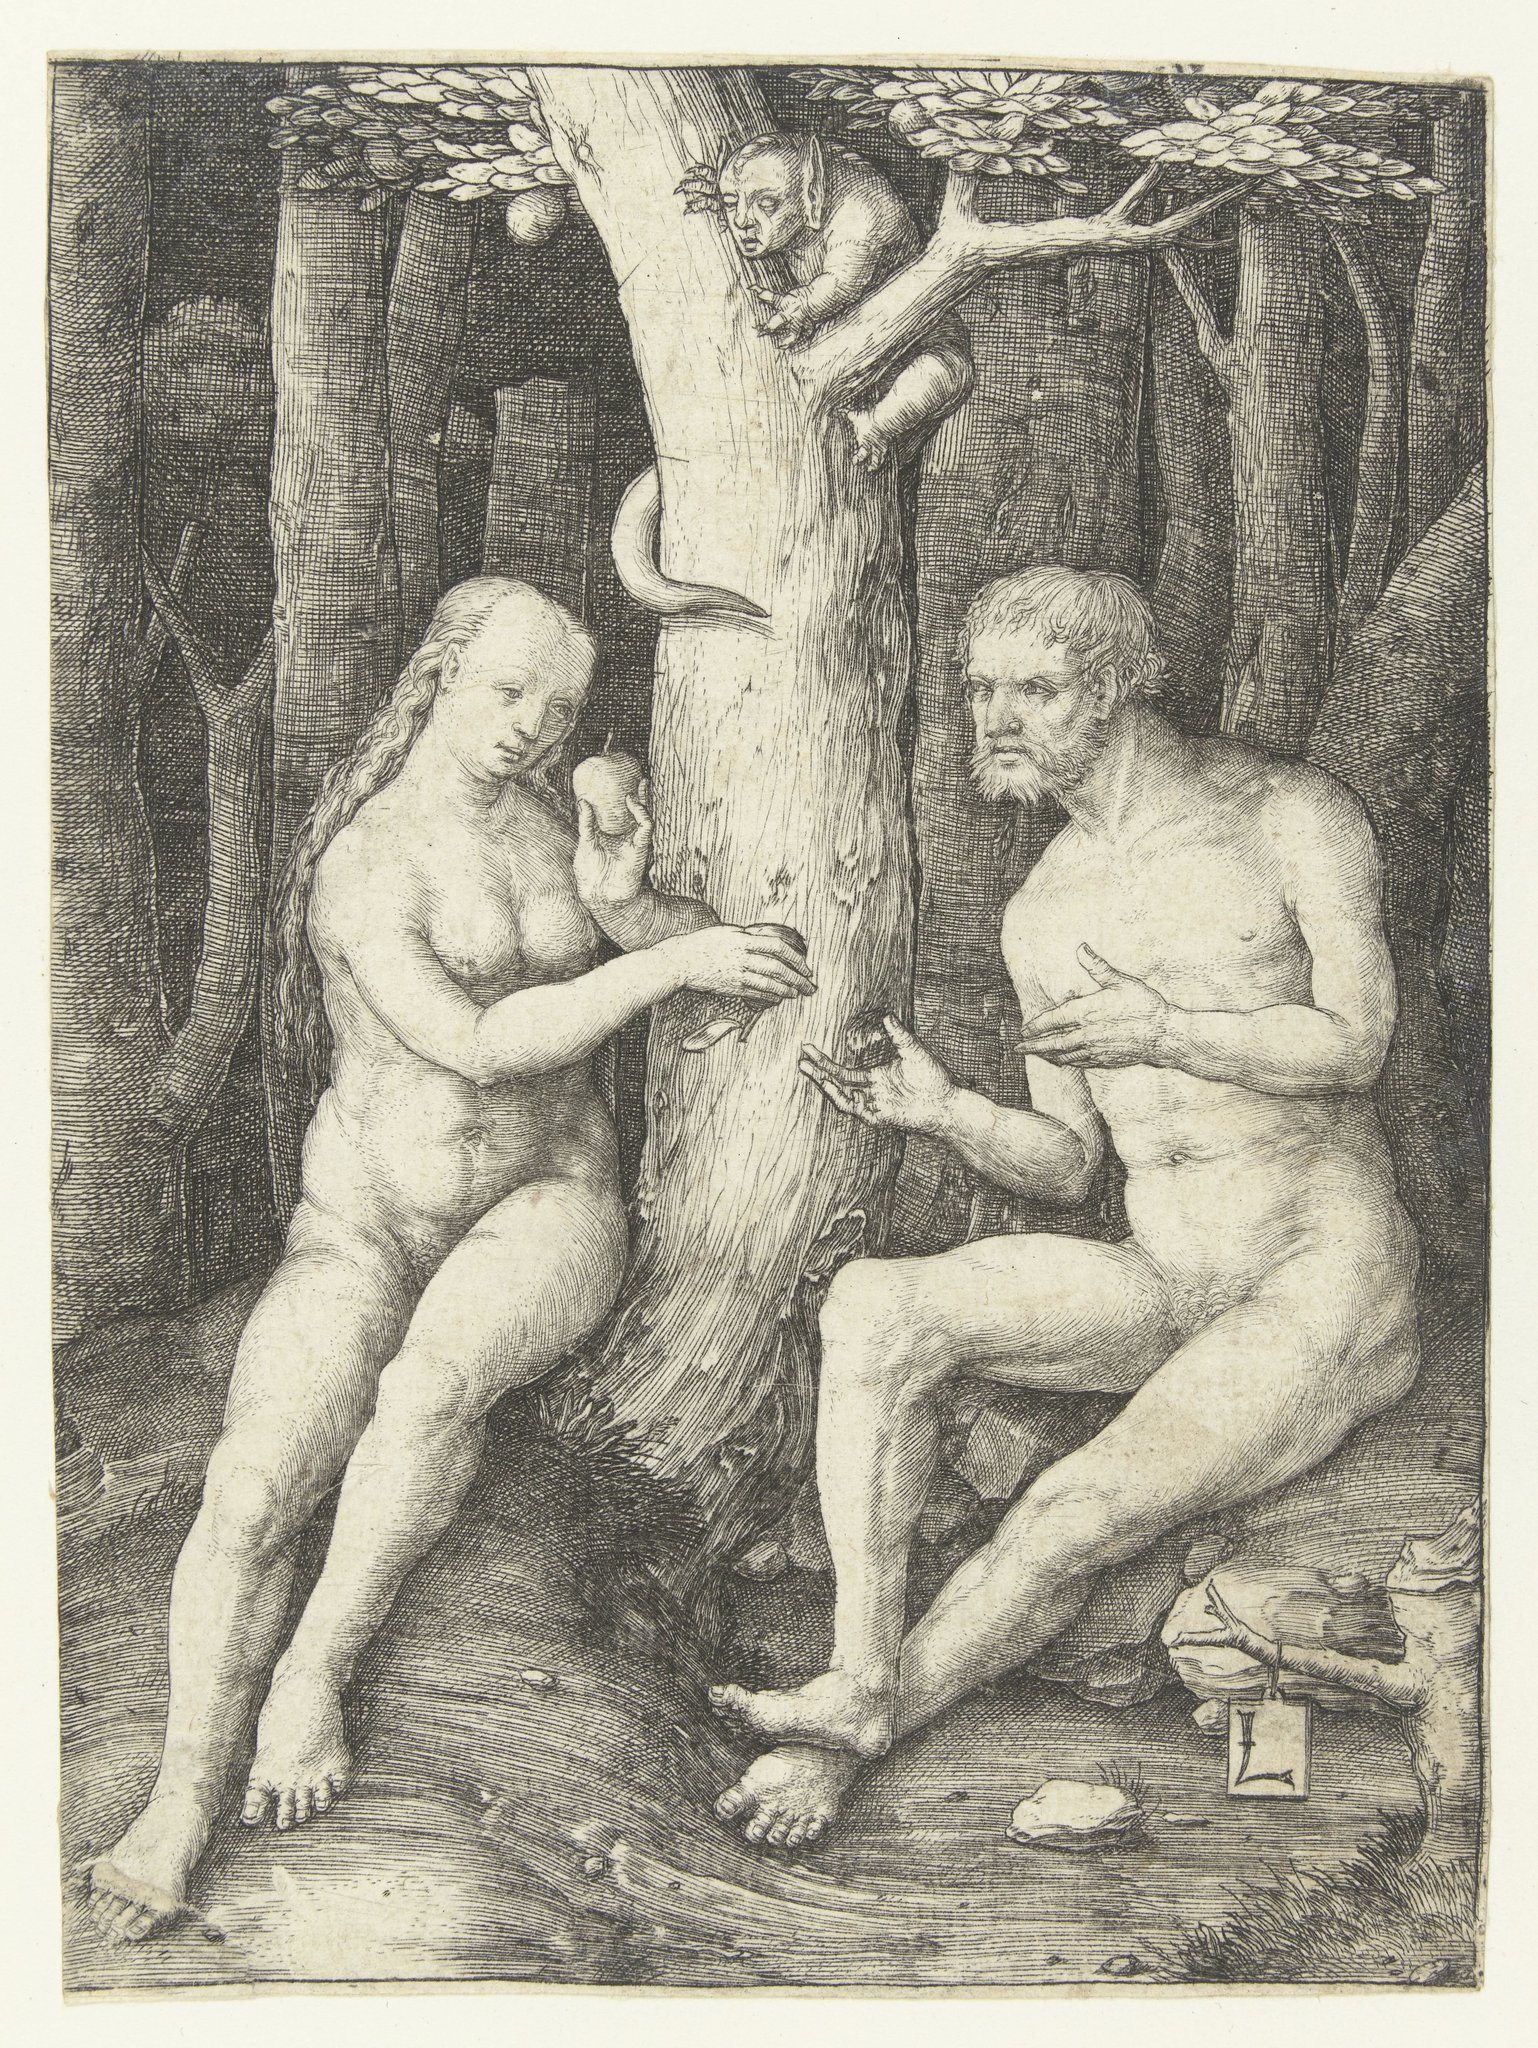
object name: print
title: De zondeval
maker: lucas van leyden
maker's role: draughtsman, painter, print maker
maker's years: 1494-1533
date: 1504-1508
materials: paper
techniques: engraving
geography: low countries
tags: eve offers the fruit to adam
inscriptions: signature: ‘L’, collector's mark: Lugt 240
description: Eva en Adam zittend aan voet van een boom. Eva met twee vruchten, overhandigt één aan Adam. In boom een duivel met een slangenstaart.